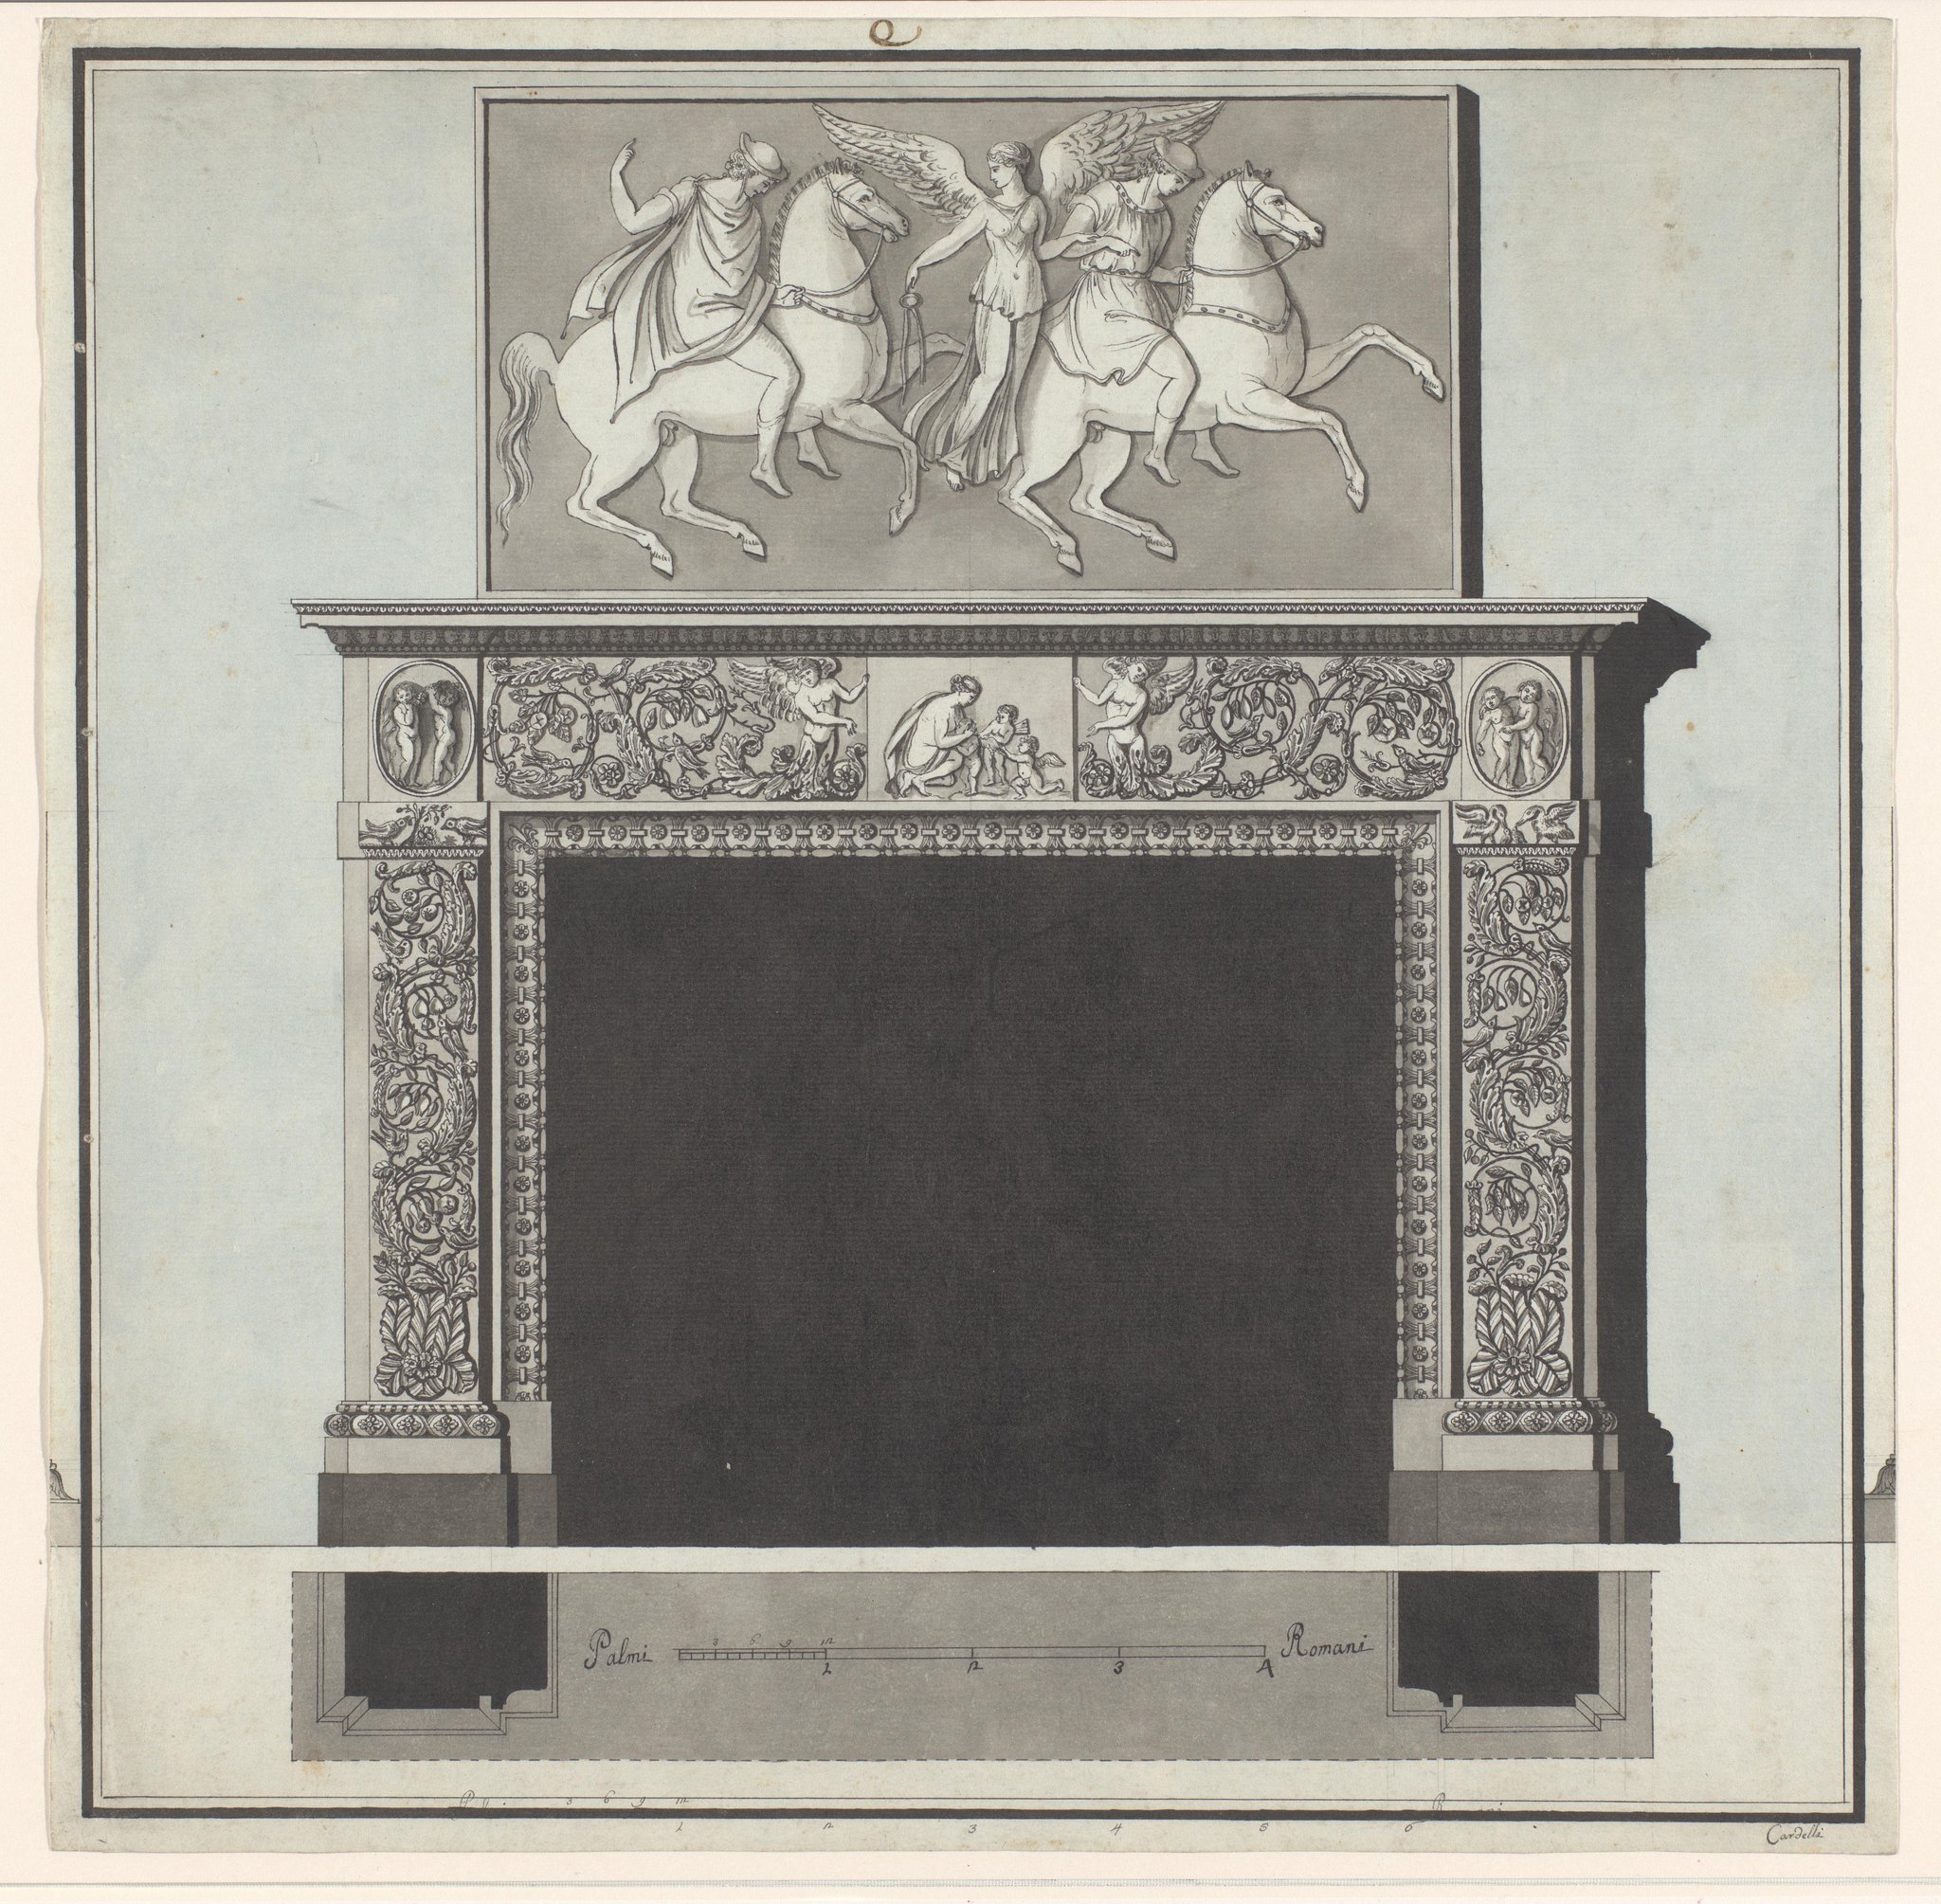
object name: design drawing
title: Schoorsteenmantel met een reliëf van een vrouw die putti de borst geeft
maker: lorenzo cardelli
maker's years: 1733-1794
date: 1790-1810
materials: graphite, paper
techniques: brush, pen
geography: rome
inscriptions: signature: ‘Cardelli’, inscription, inscription: ‘Q’, watermark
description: Schoorsteenmantel met een reliëf van een vrouw die putti de borst geeft, twee ovale reliëfs van naakte kinderen, en bladranken met halffiguren en vogels, met daaronder een plattegrond, en boven de mantel een reliëf van twee gehelmde ruiters en een zwevende geveugelde vrouwenfiguur.